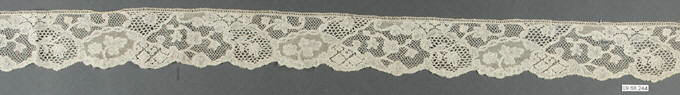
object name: strip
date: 1701-1800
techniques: lace